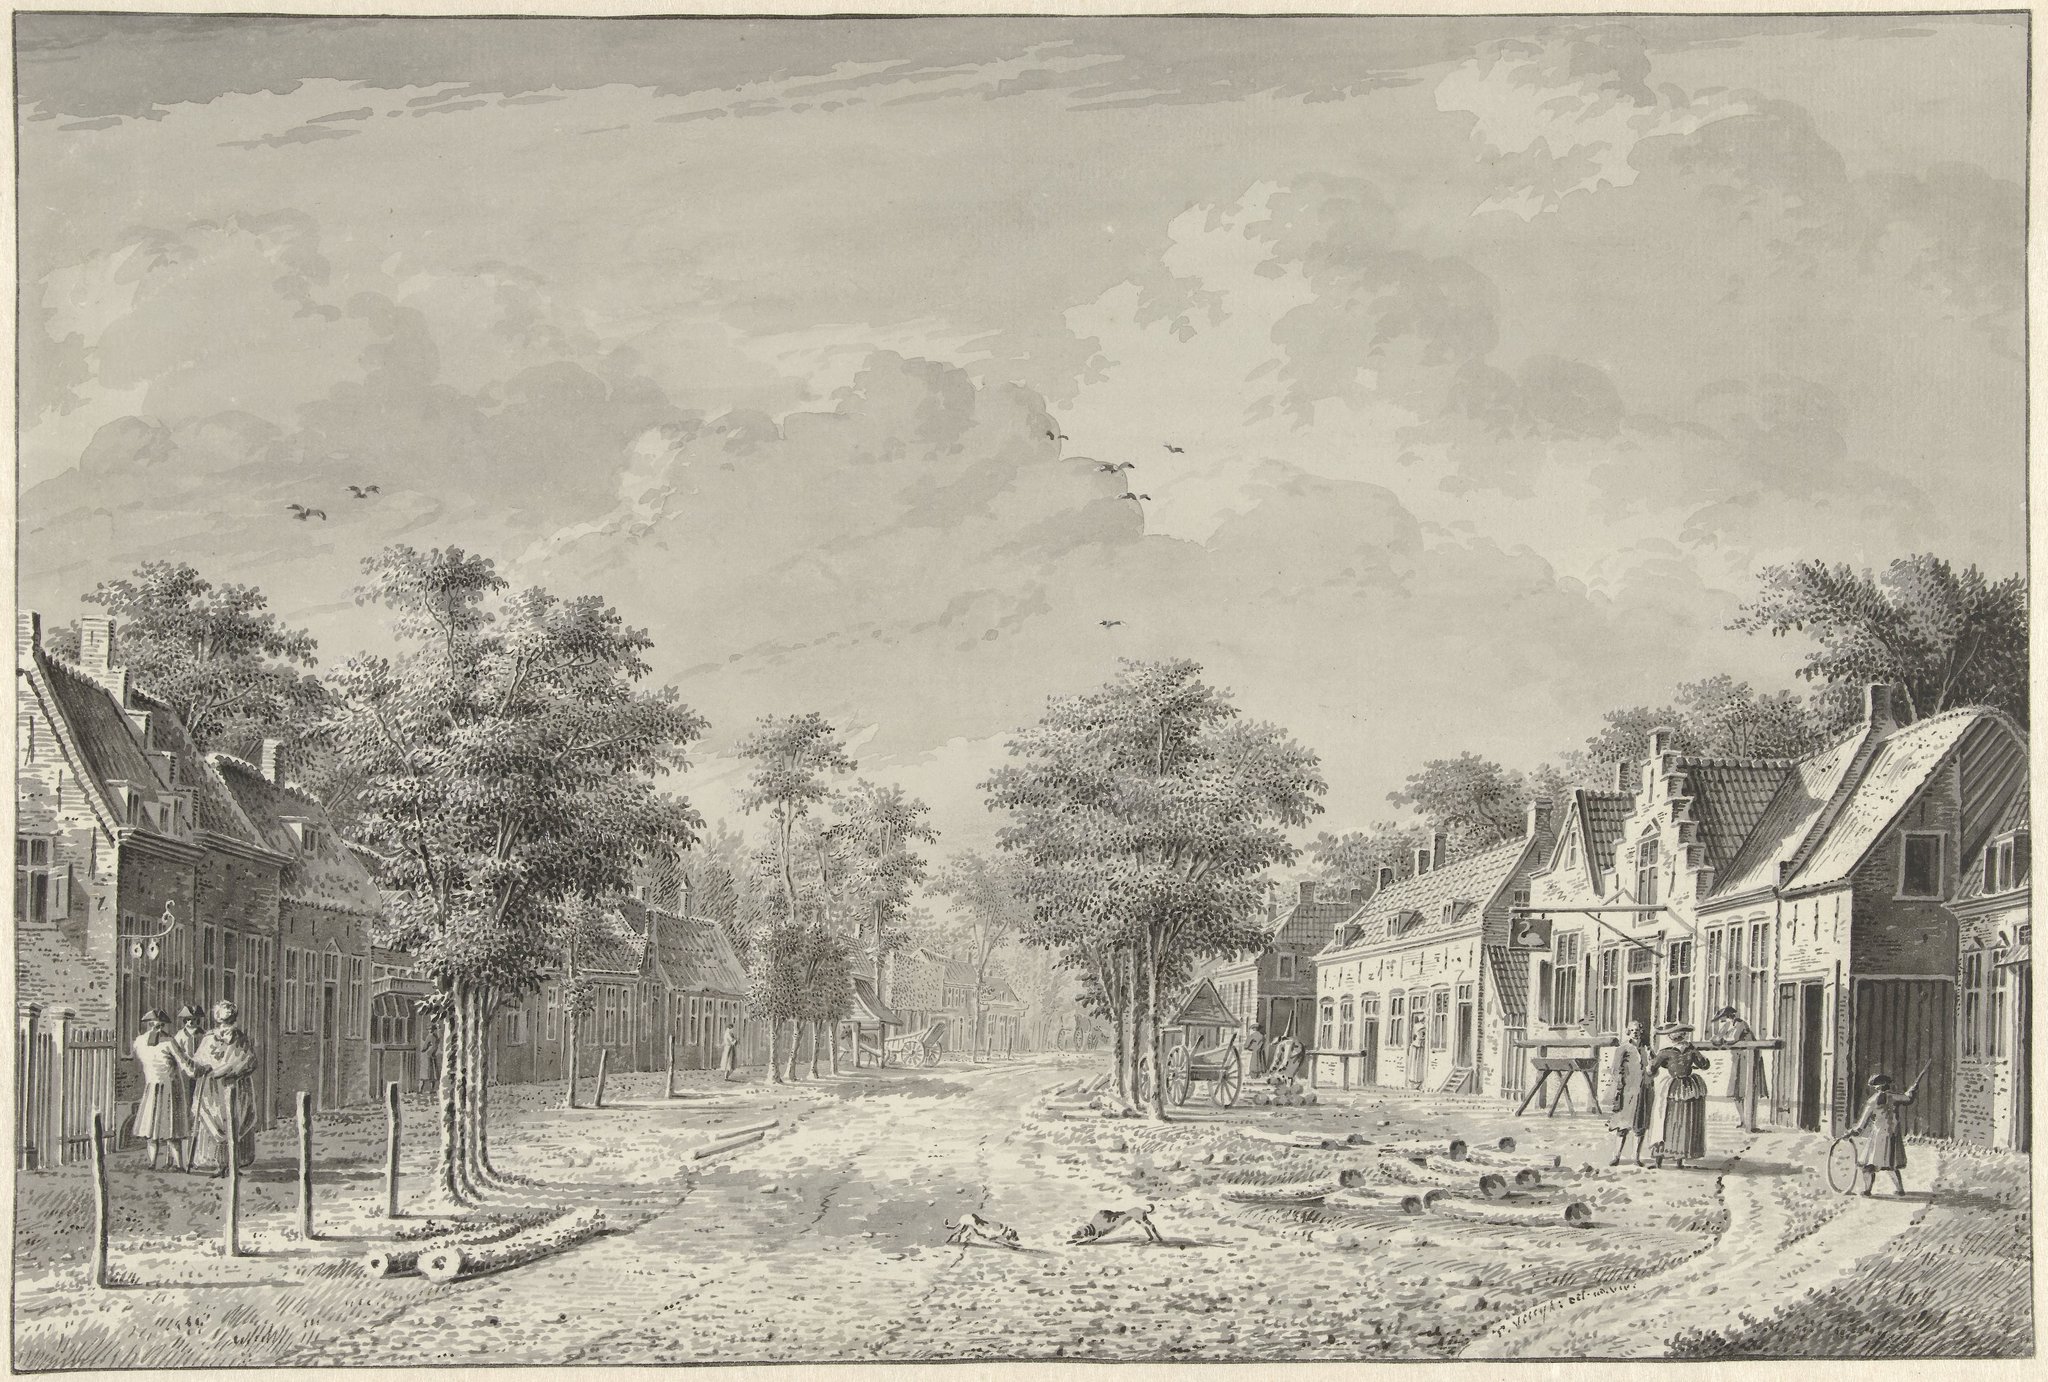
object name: drawing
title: Gezicht op het dorp De Bilt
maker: dirk verrijk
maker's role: draughtsman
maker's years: 1734-1786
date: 1751-1816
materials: ink, paper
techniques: brush, pen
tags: public road in village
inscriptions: inscription: ‘Gezigt het dorp de Bild 1/2 uur van de Stad Utrecht’, signature: ‘T. Verryk del. ad. viv’